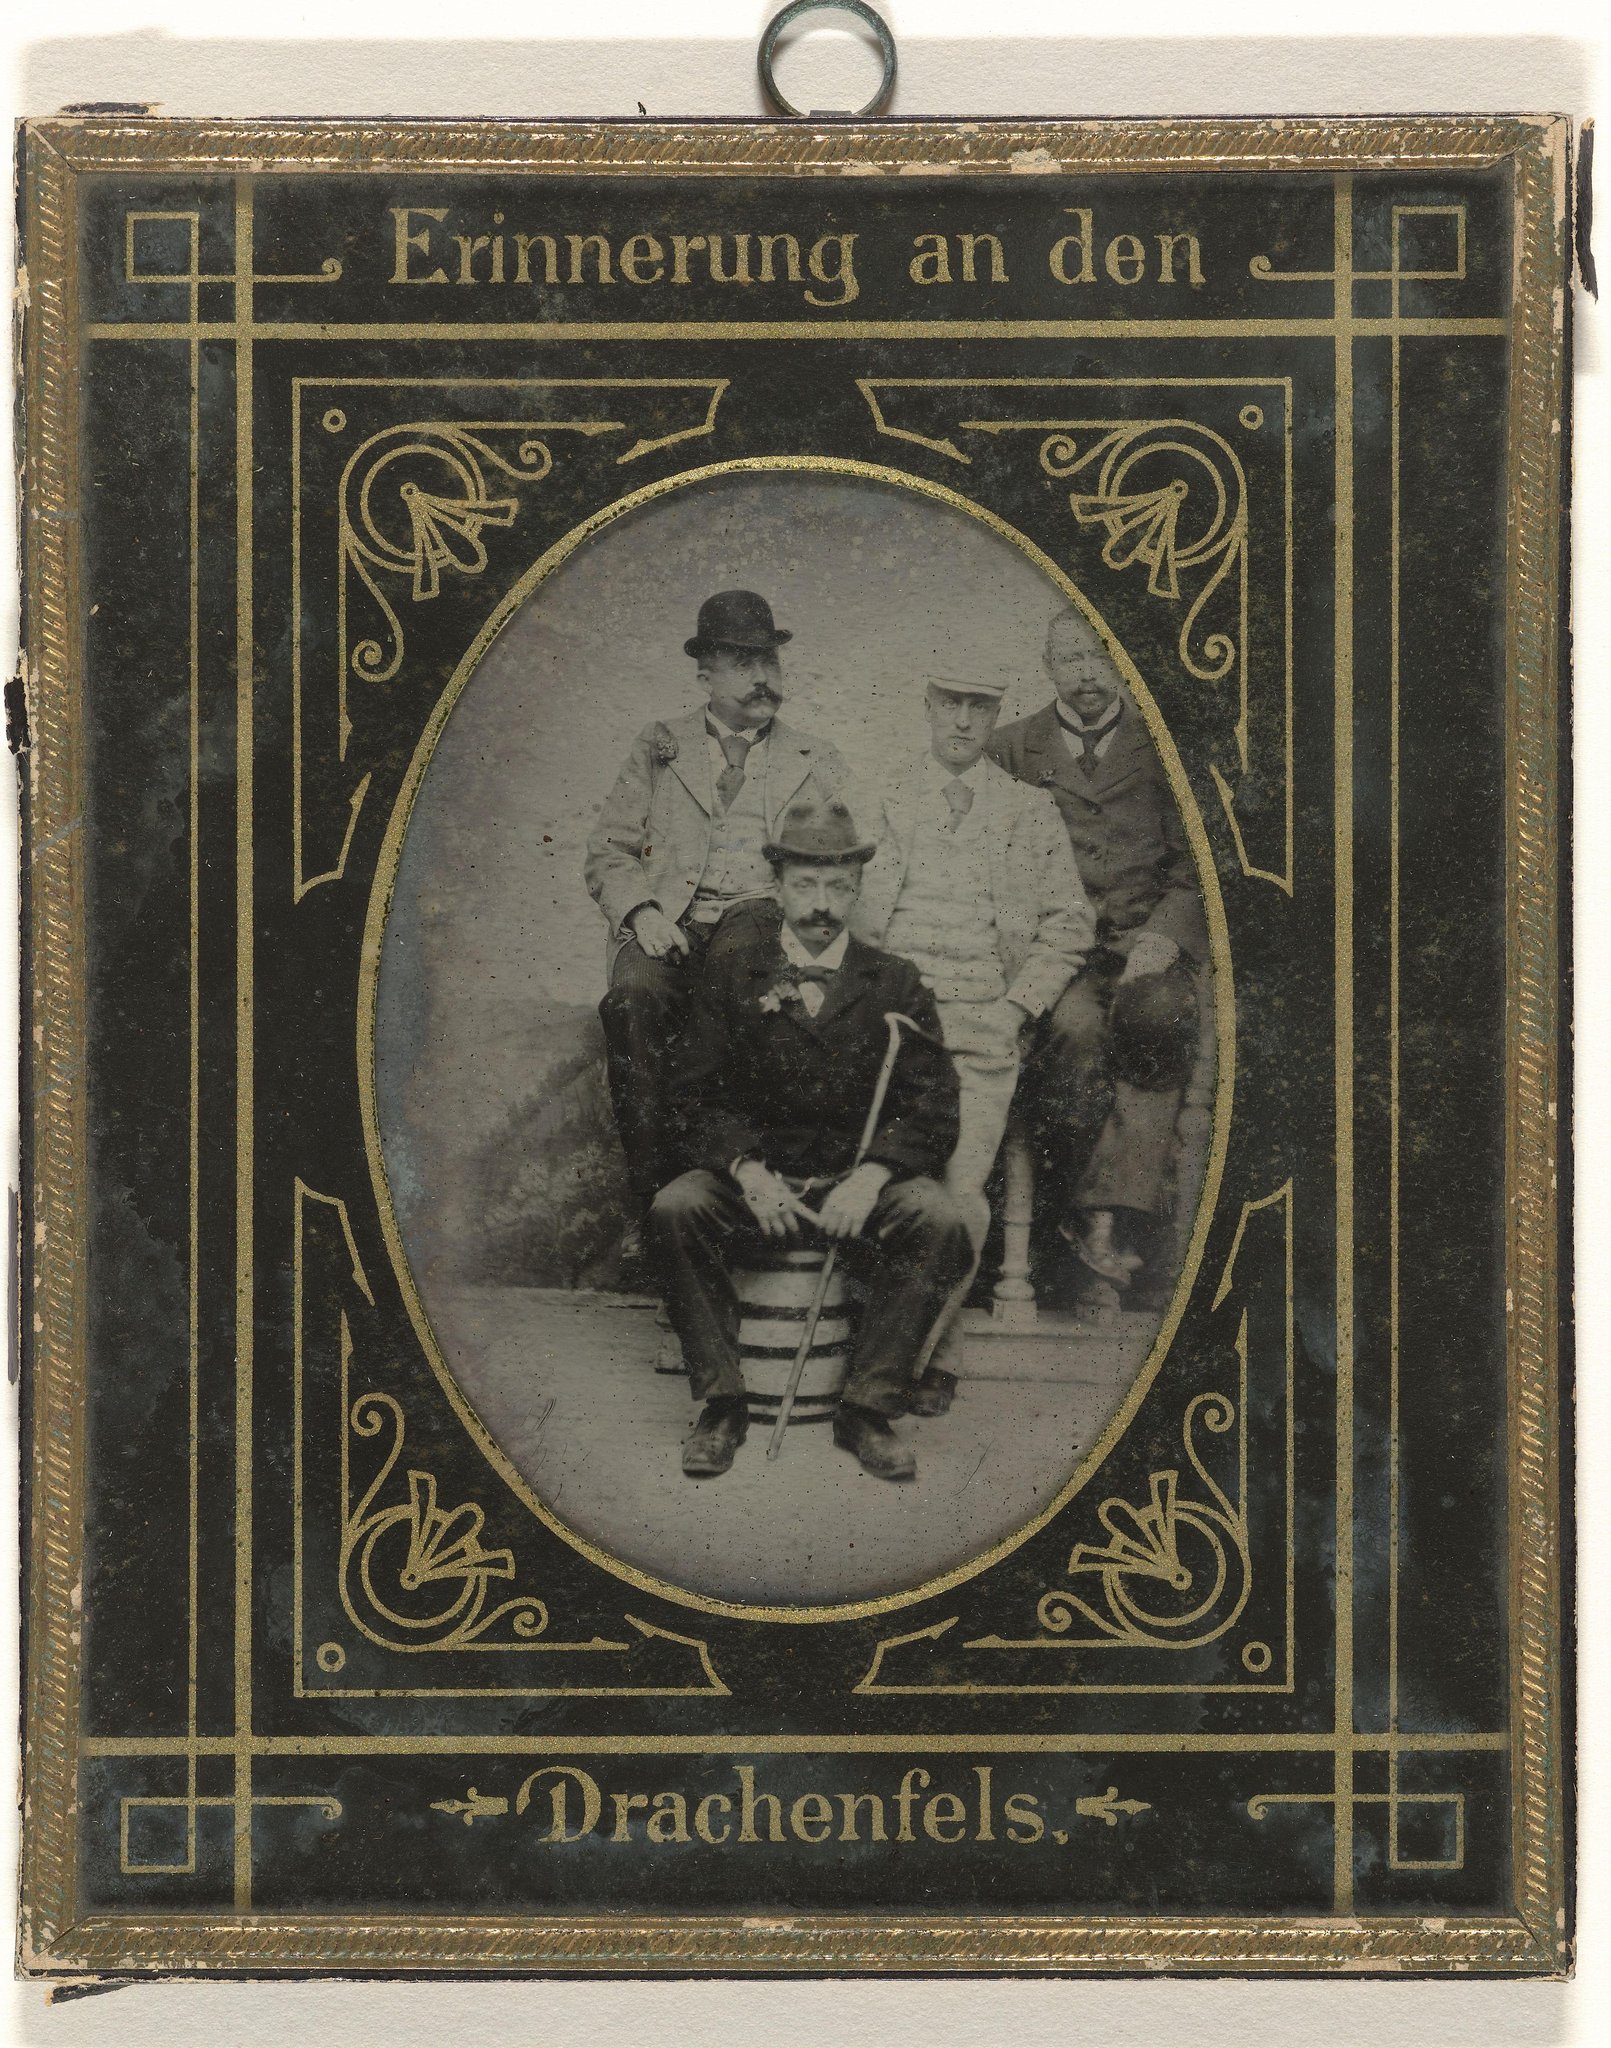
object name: photograph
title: Portret van vier mannen, staand en zittend op een ton en een balustrade, Drachenfels, Duitsland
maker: ed. fischer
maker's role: fotograaf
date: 1895-1918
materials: glass, metal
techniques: ferrotyping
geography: germany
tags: drachenfels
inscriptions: annotation: ‘Erinnerung an den / Drachenfels’, annotation: ‘Laut Verfügung des Kaiserlichen Patent- / amtes in Berlin vom 17. December 1895, / No. 12063 (Klasse 28) ist umstehendes / Rahmenmuster mit der Aufschrift 'Erinne- / rung an den Drachenfels' gegen Nach- / ahmung geschützt und werden wider- / rechtliche Nachahmungen auf Grund des / Gesetzes vom 12. Mai 1894 bestraft. / Ed. Fischer. / Photograph auf dem Drachenfels.’